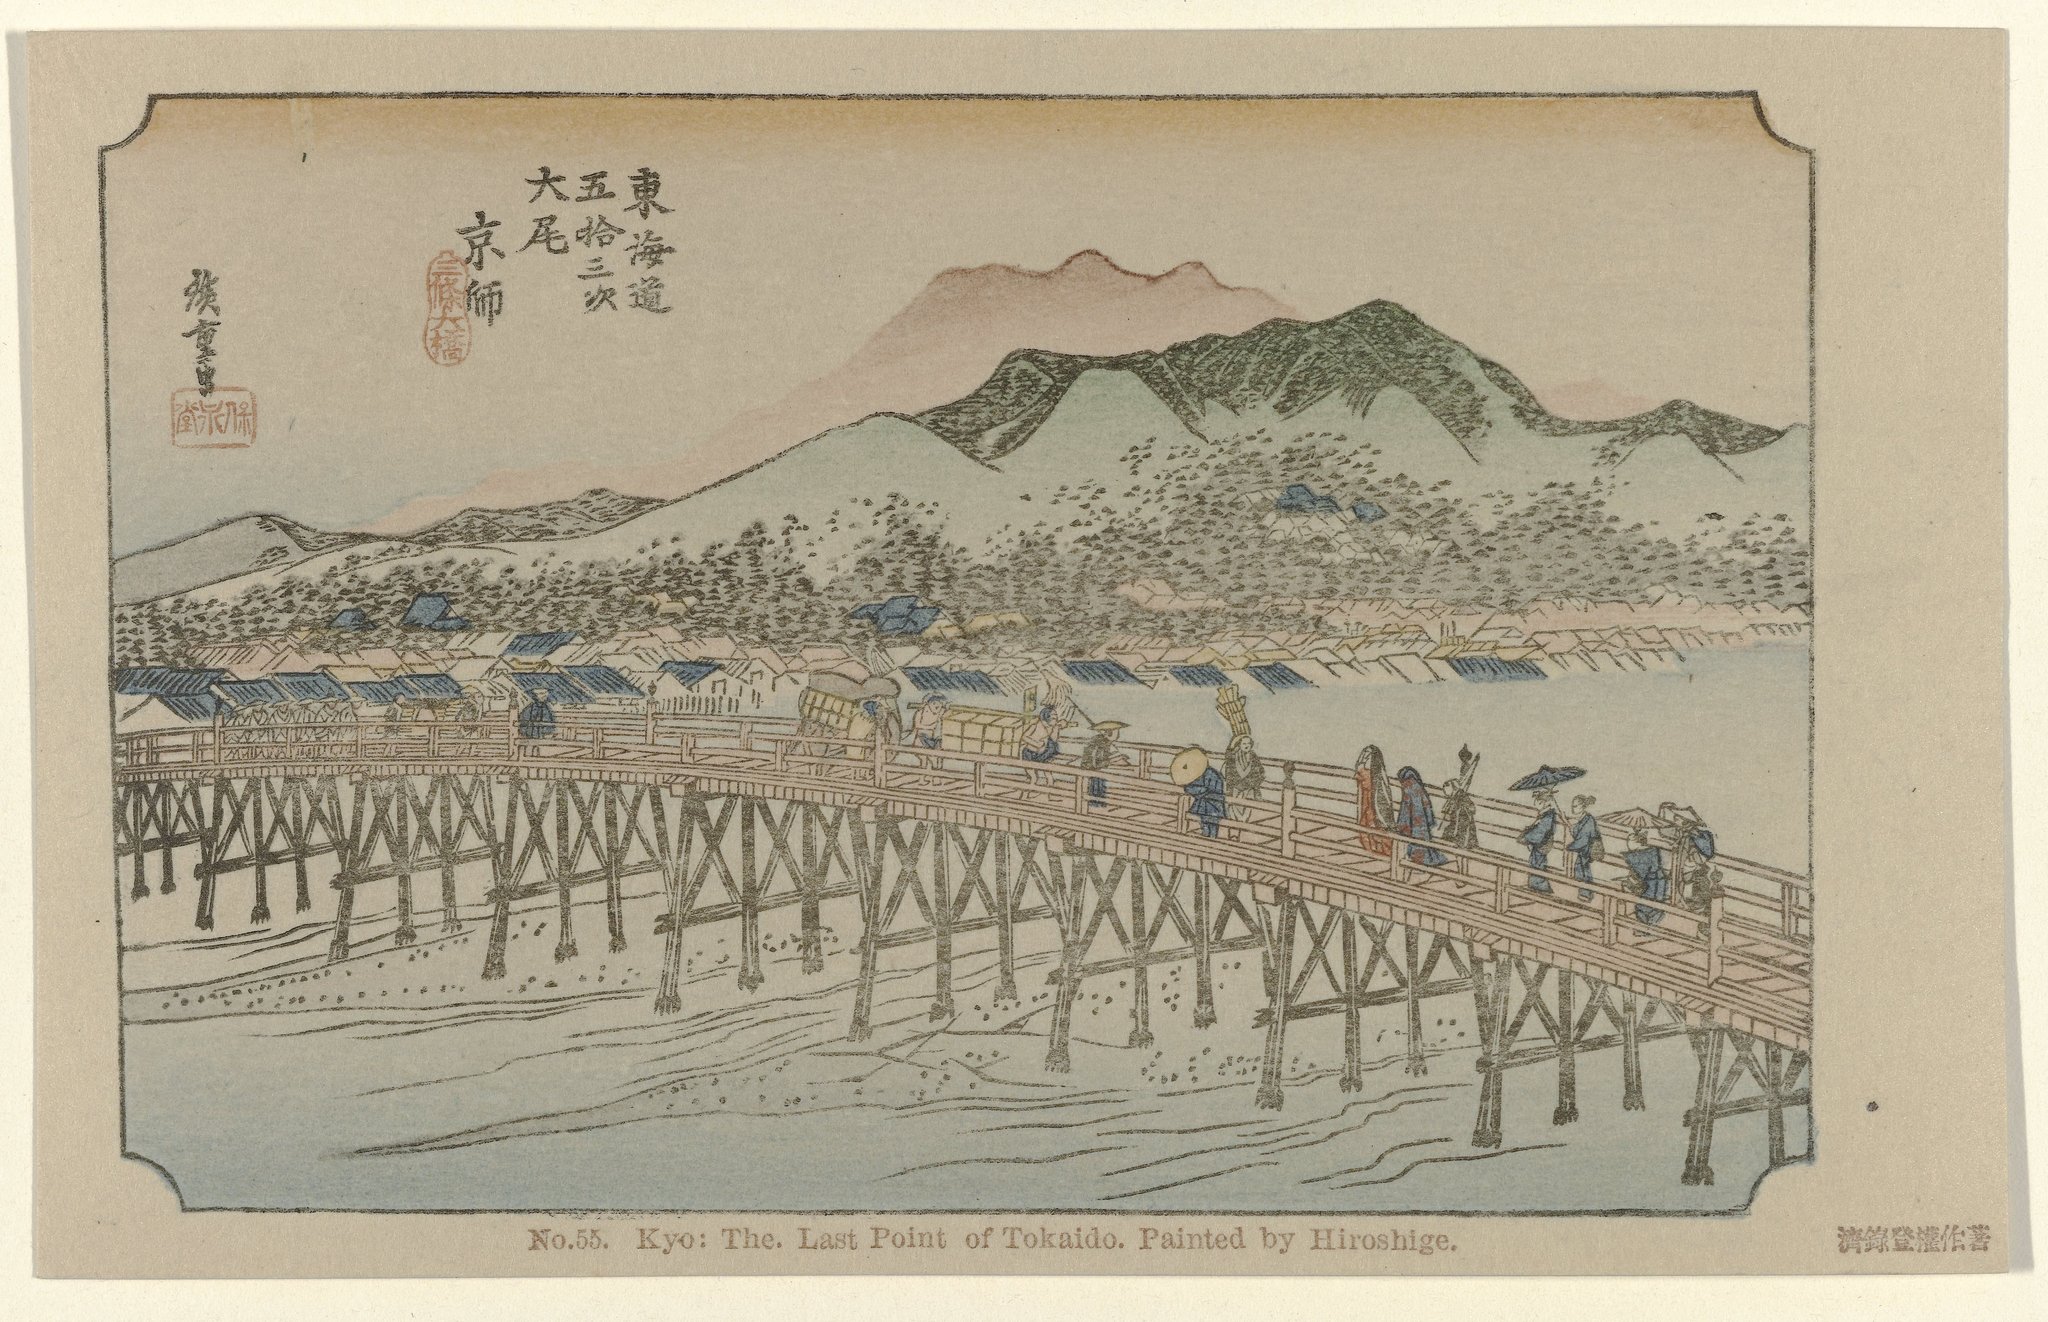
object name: ansichtkaart, prentbriefkaart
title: No. 55. Kyo, the last point of Tokaido, painted by Hiroshige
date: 1906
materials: cardboard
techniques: woodcut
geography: japan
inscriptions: date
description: De brug over de Kamo rivier met reizigers, herkenbaar aan hun strooien hoeden.